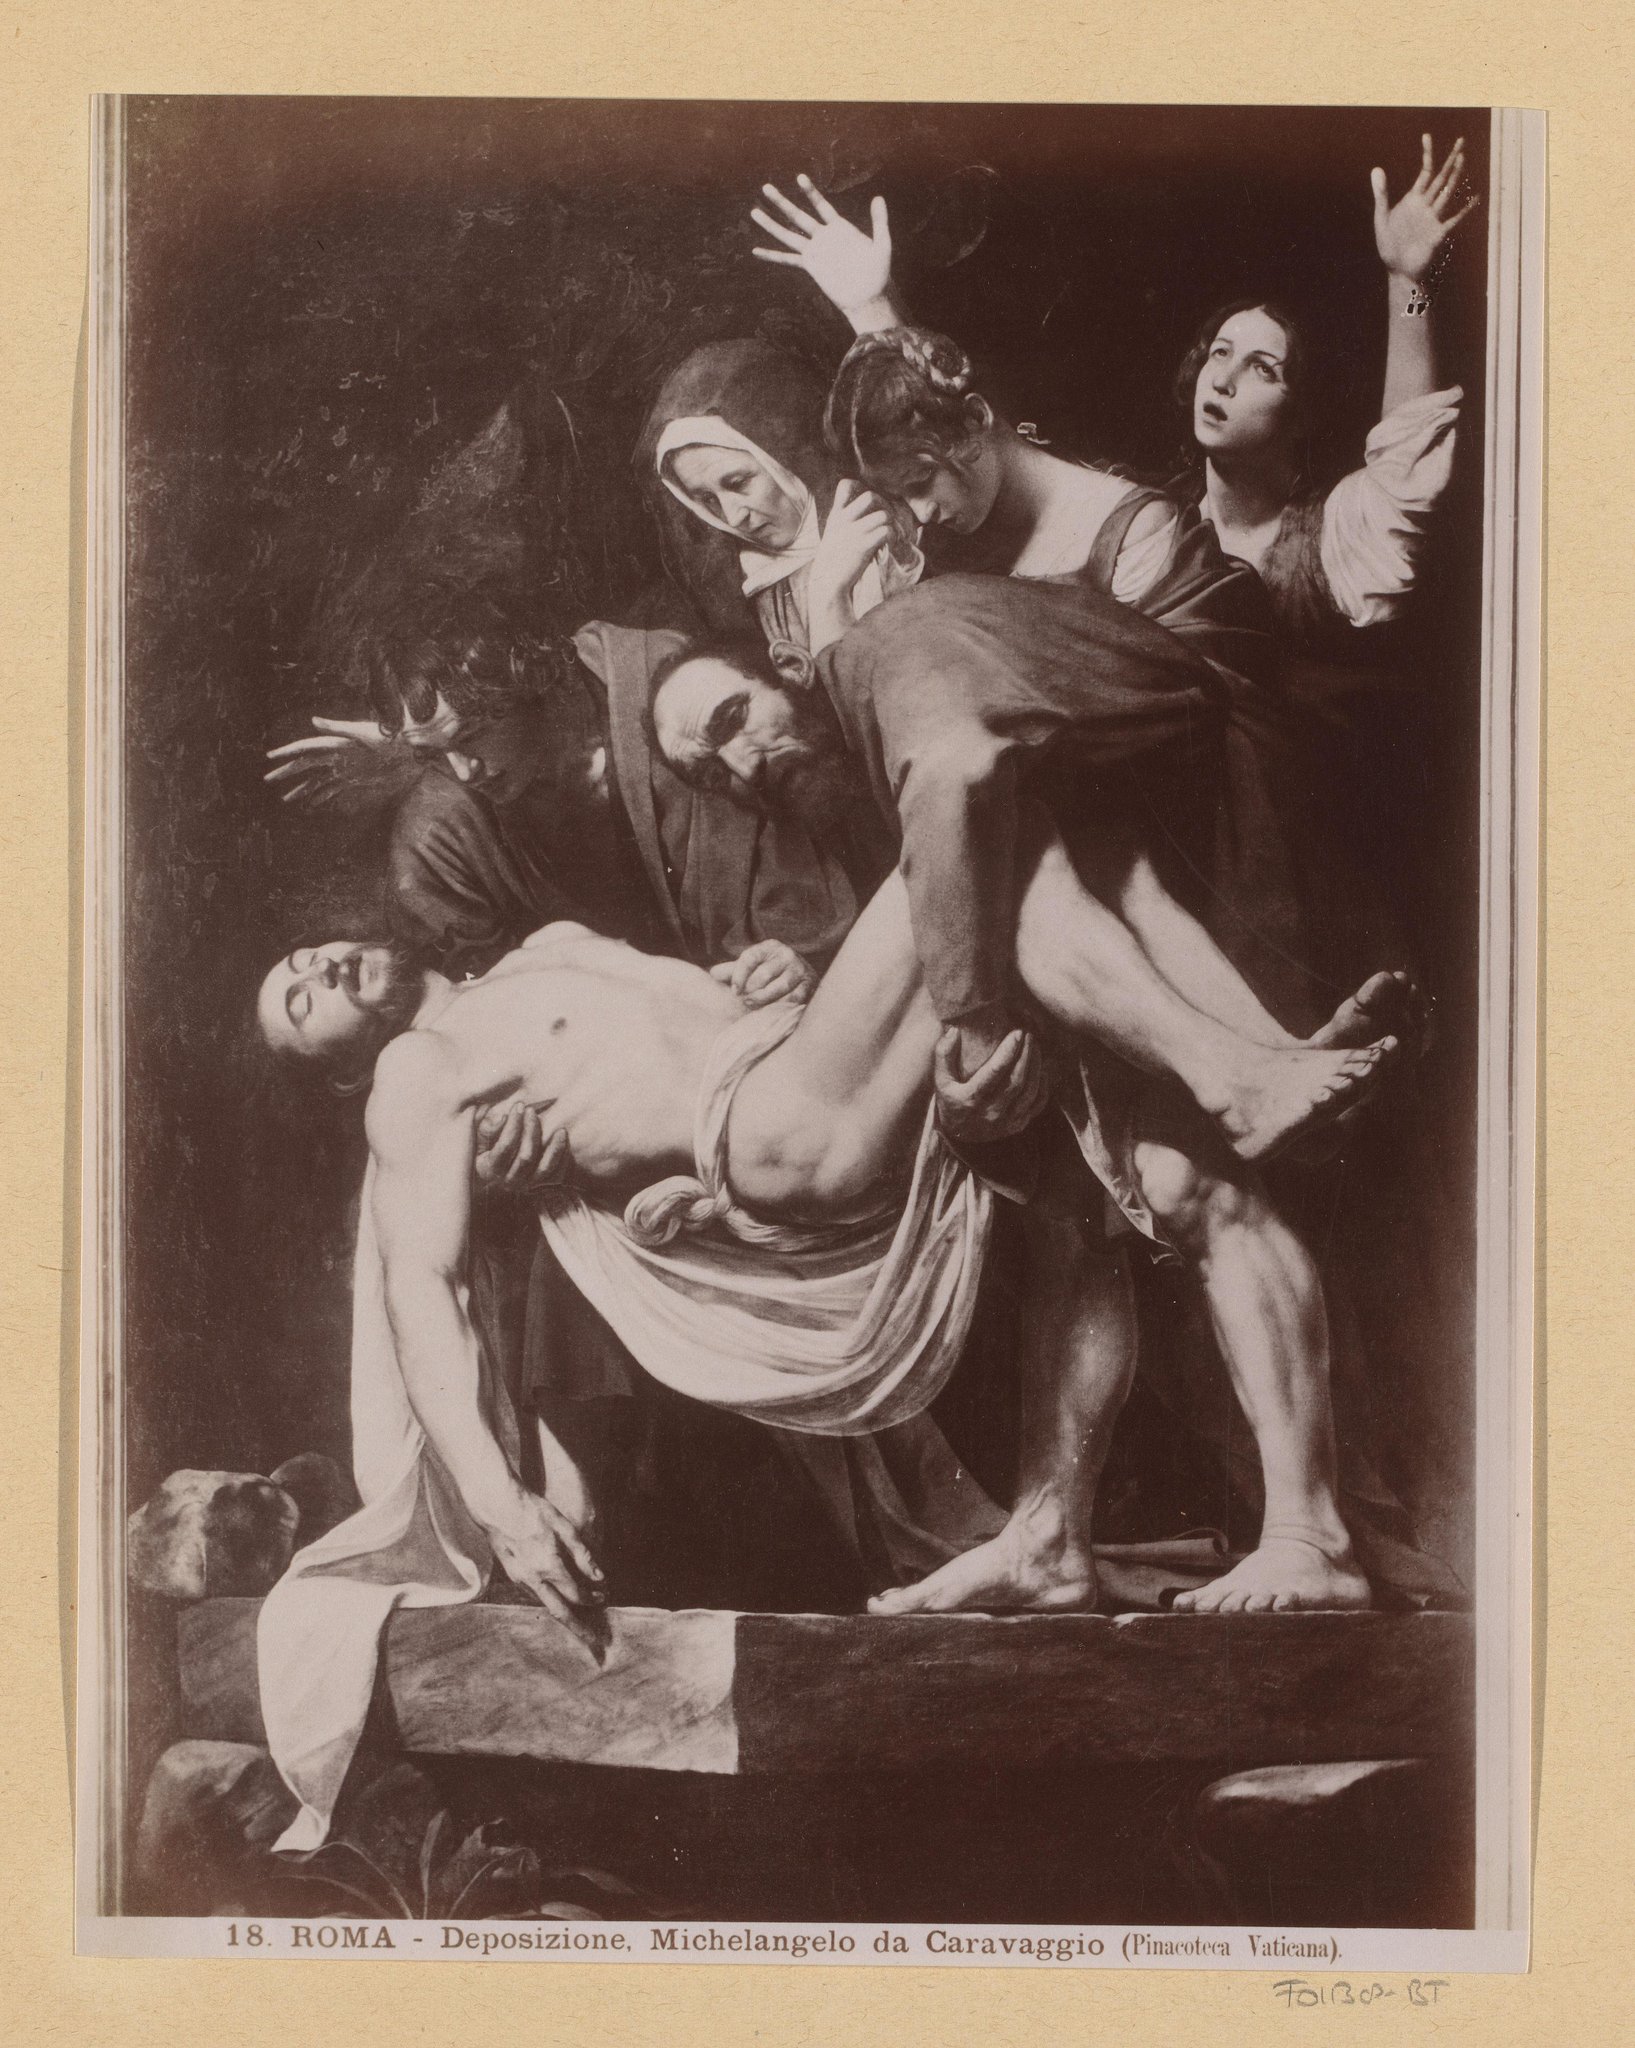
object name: photograph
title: Fotoreproductie van het schilderij De graflegging door Caravaggio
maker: Anonymous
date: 1860-1900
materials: photographic support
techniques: albumen print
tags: christ's entombment (possibly by angels)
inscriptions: number: ‘18’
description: Onderdeel van Reisalbum met opnames van kunstwerken en bezienswaardigheden in Italië, Griekenland en Frankrijk.